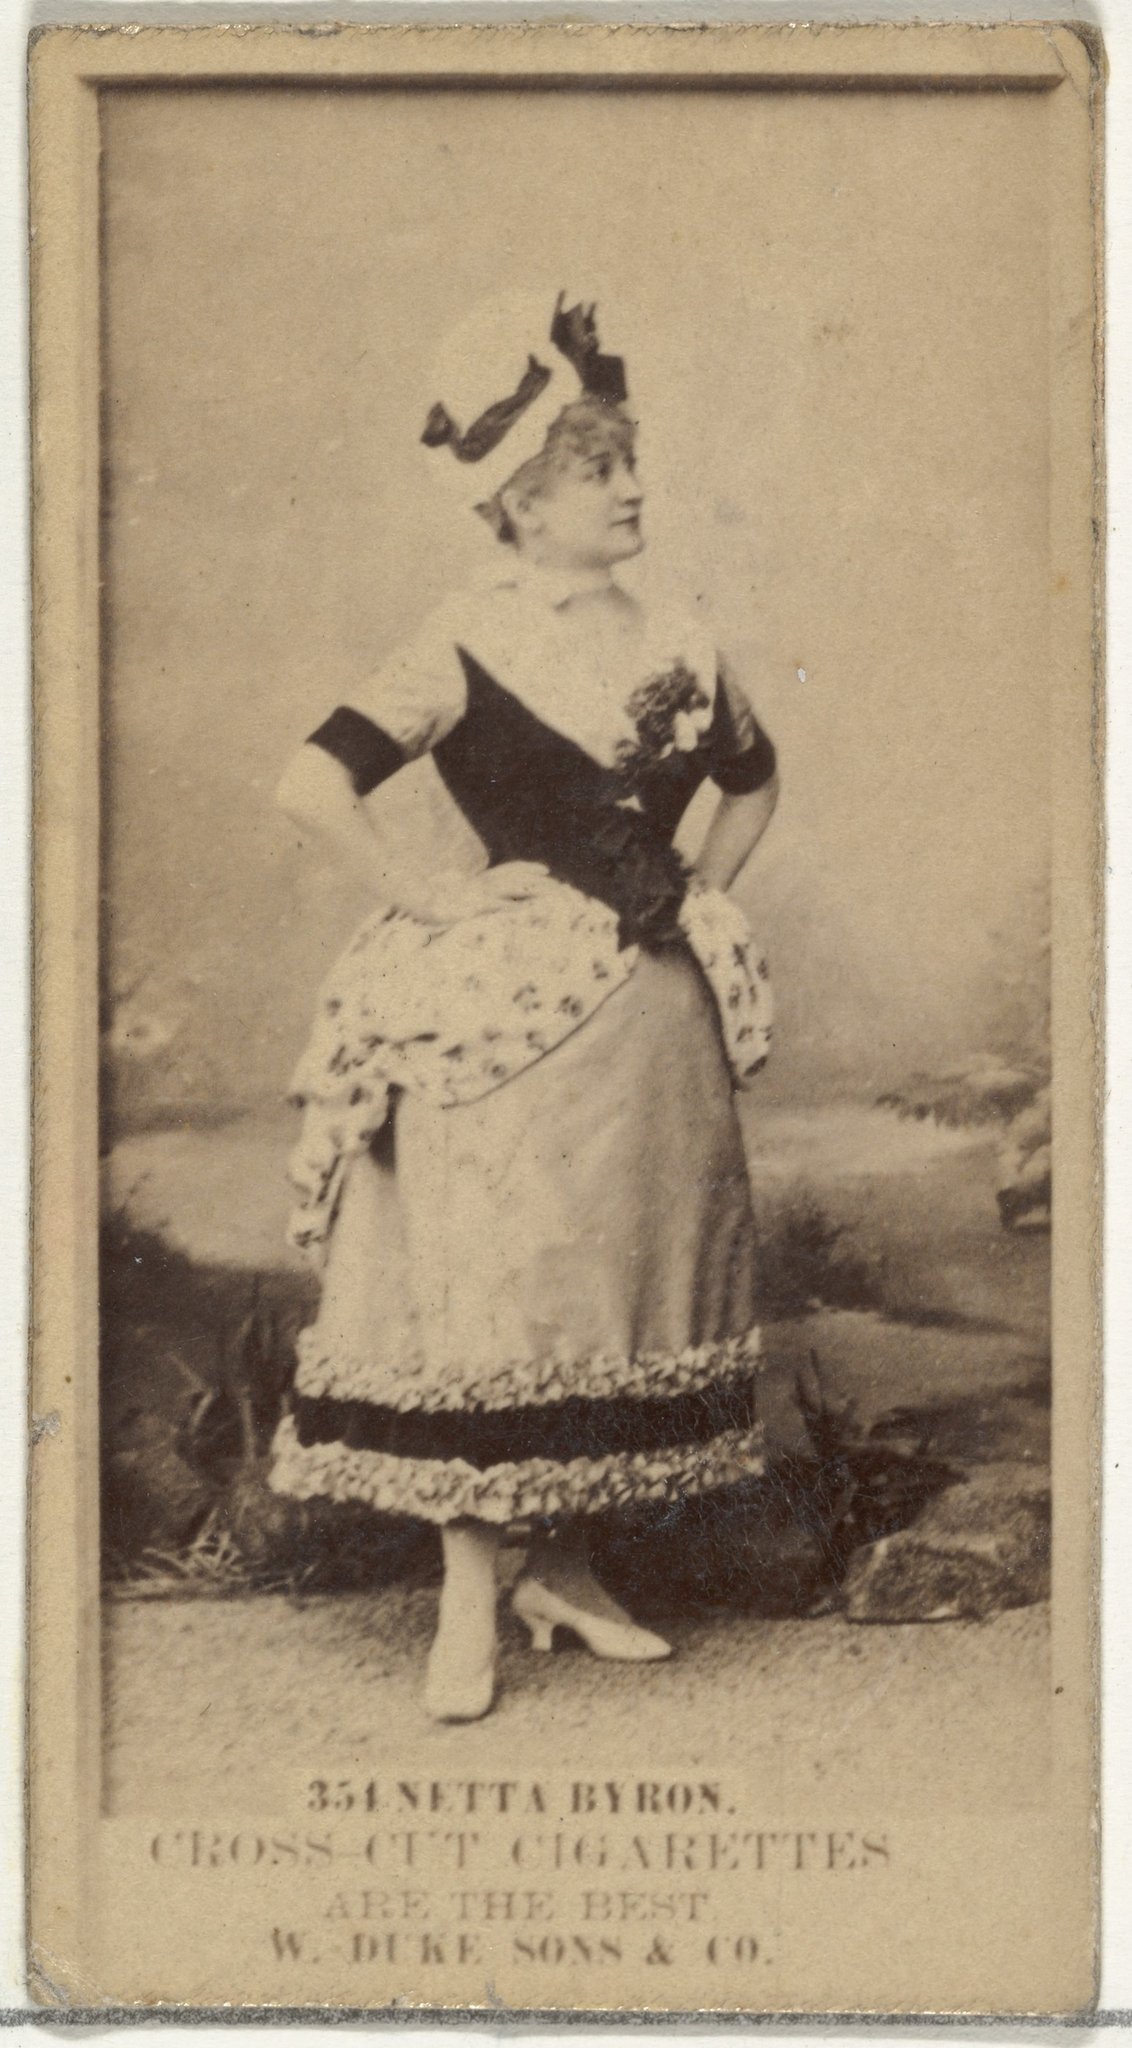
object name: photograph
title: Card Number 354, Netta Byron, from the Actors and Actresses series (N145-3) issued by Duke Sons & Co. to promote Cross Cut Cigarettes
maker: w. duke, sons & co.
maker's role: publisher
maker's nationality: american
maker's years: 1870-1920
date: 1880-1889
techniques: albumen silver print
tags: portraits,women,actresses